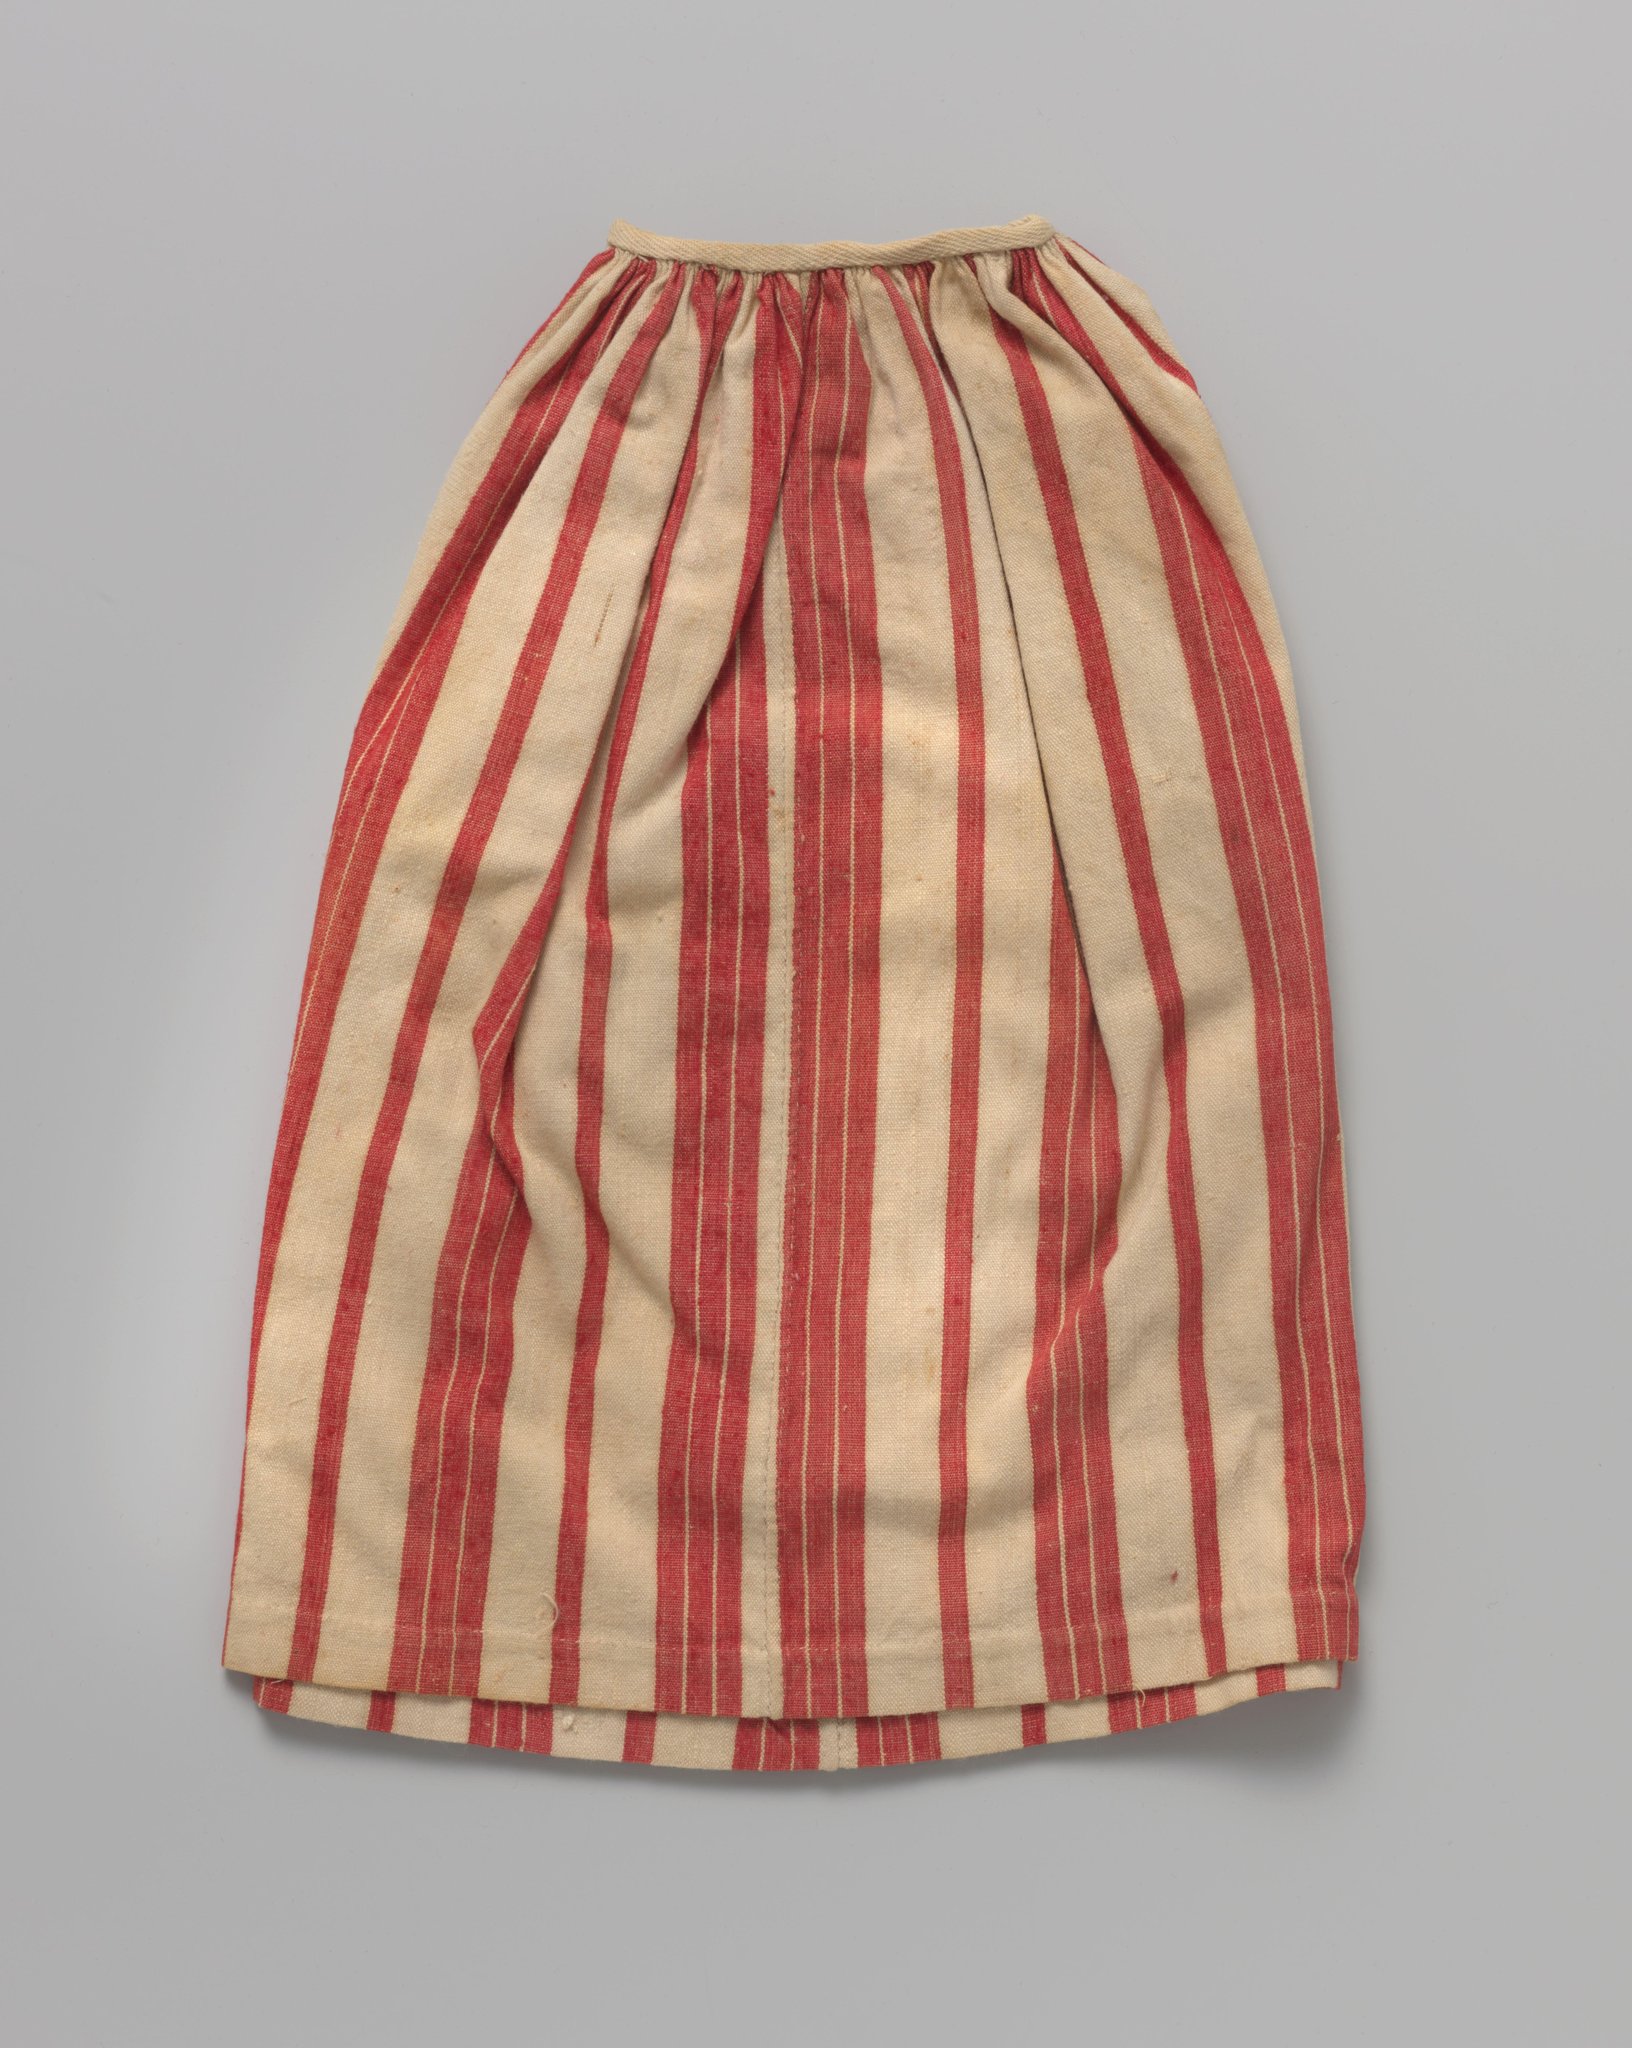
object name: skirt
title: Onderrok van rood en wit gestreepte keperkatoen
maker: Anonymous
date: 1850-1900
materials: cotton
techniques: weave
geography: netherlands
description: Onderrok van rood en wit gestreepte keperkatoen.